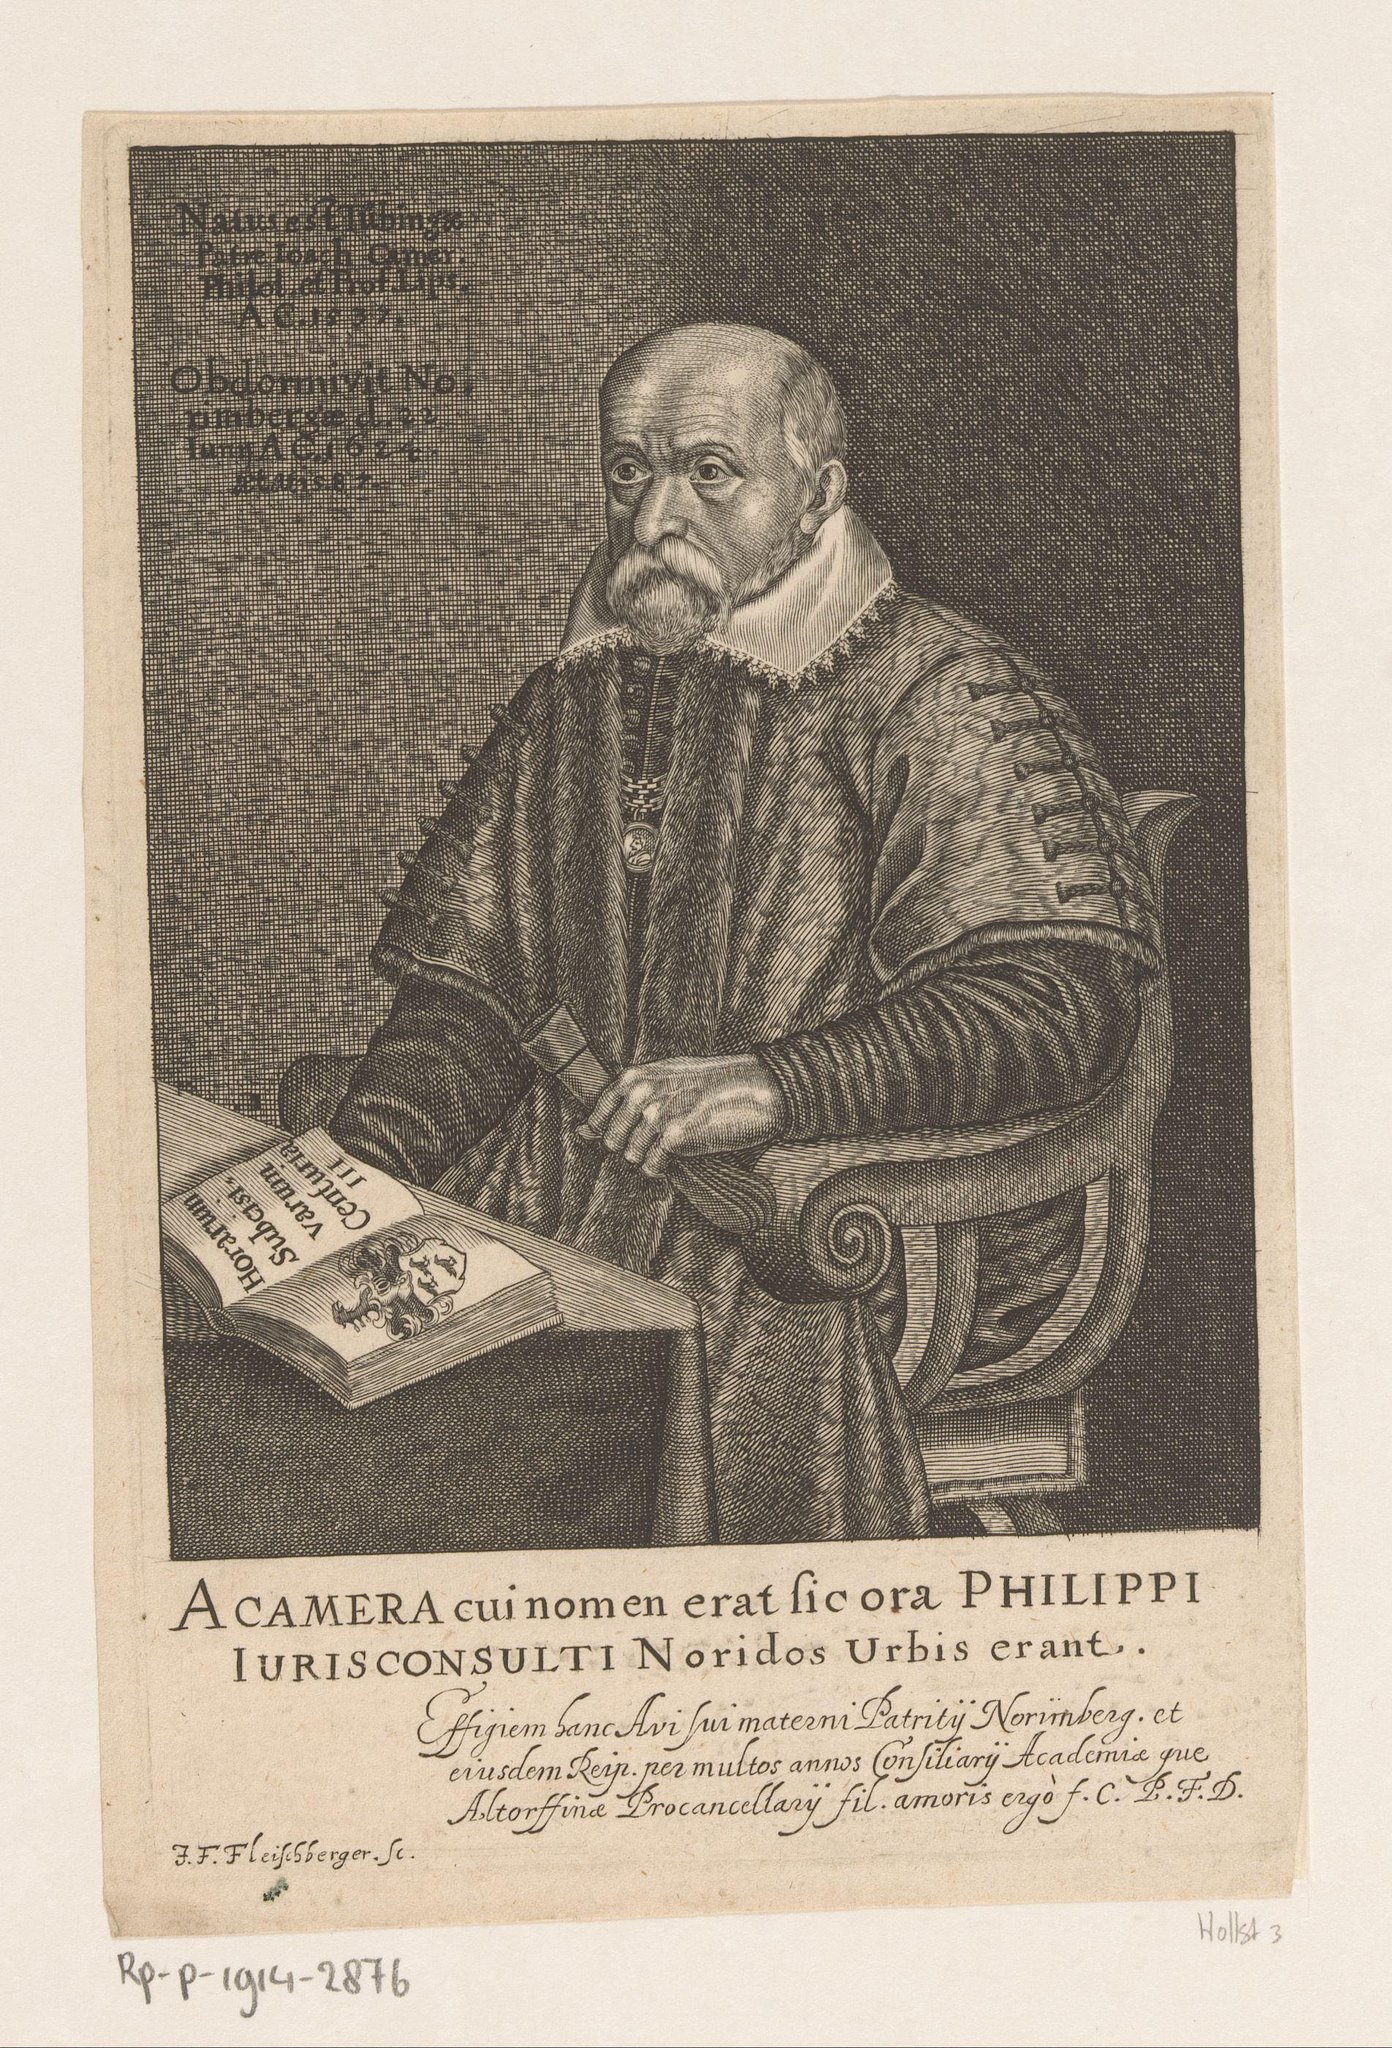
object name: print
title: Portret van Philipp Camerarius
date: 1641-1665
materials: paper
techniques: engraving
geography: nuremberg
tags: gloves, mittens, etc., historical persons, book, armorial bearing, heraldry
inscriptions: collector's mark: Lugt 2228